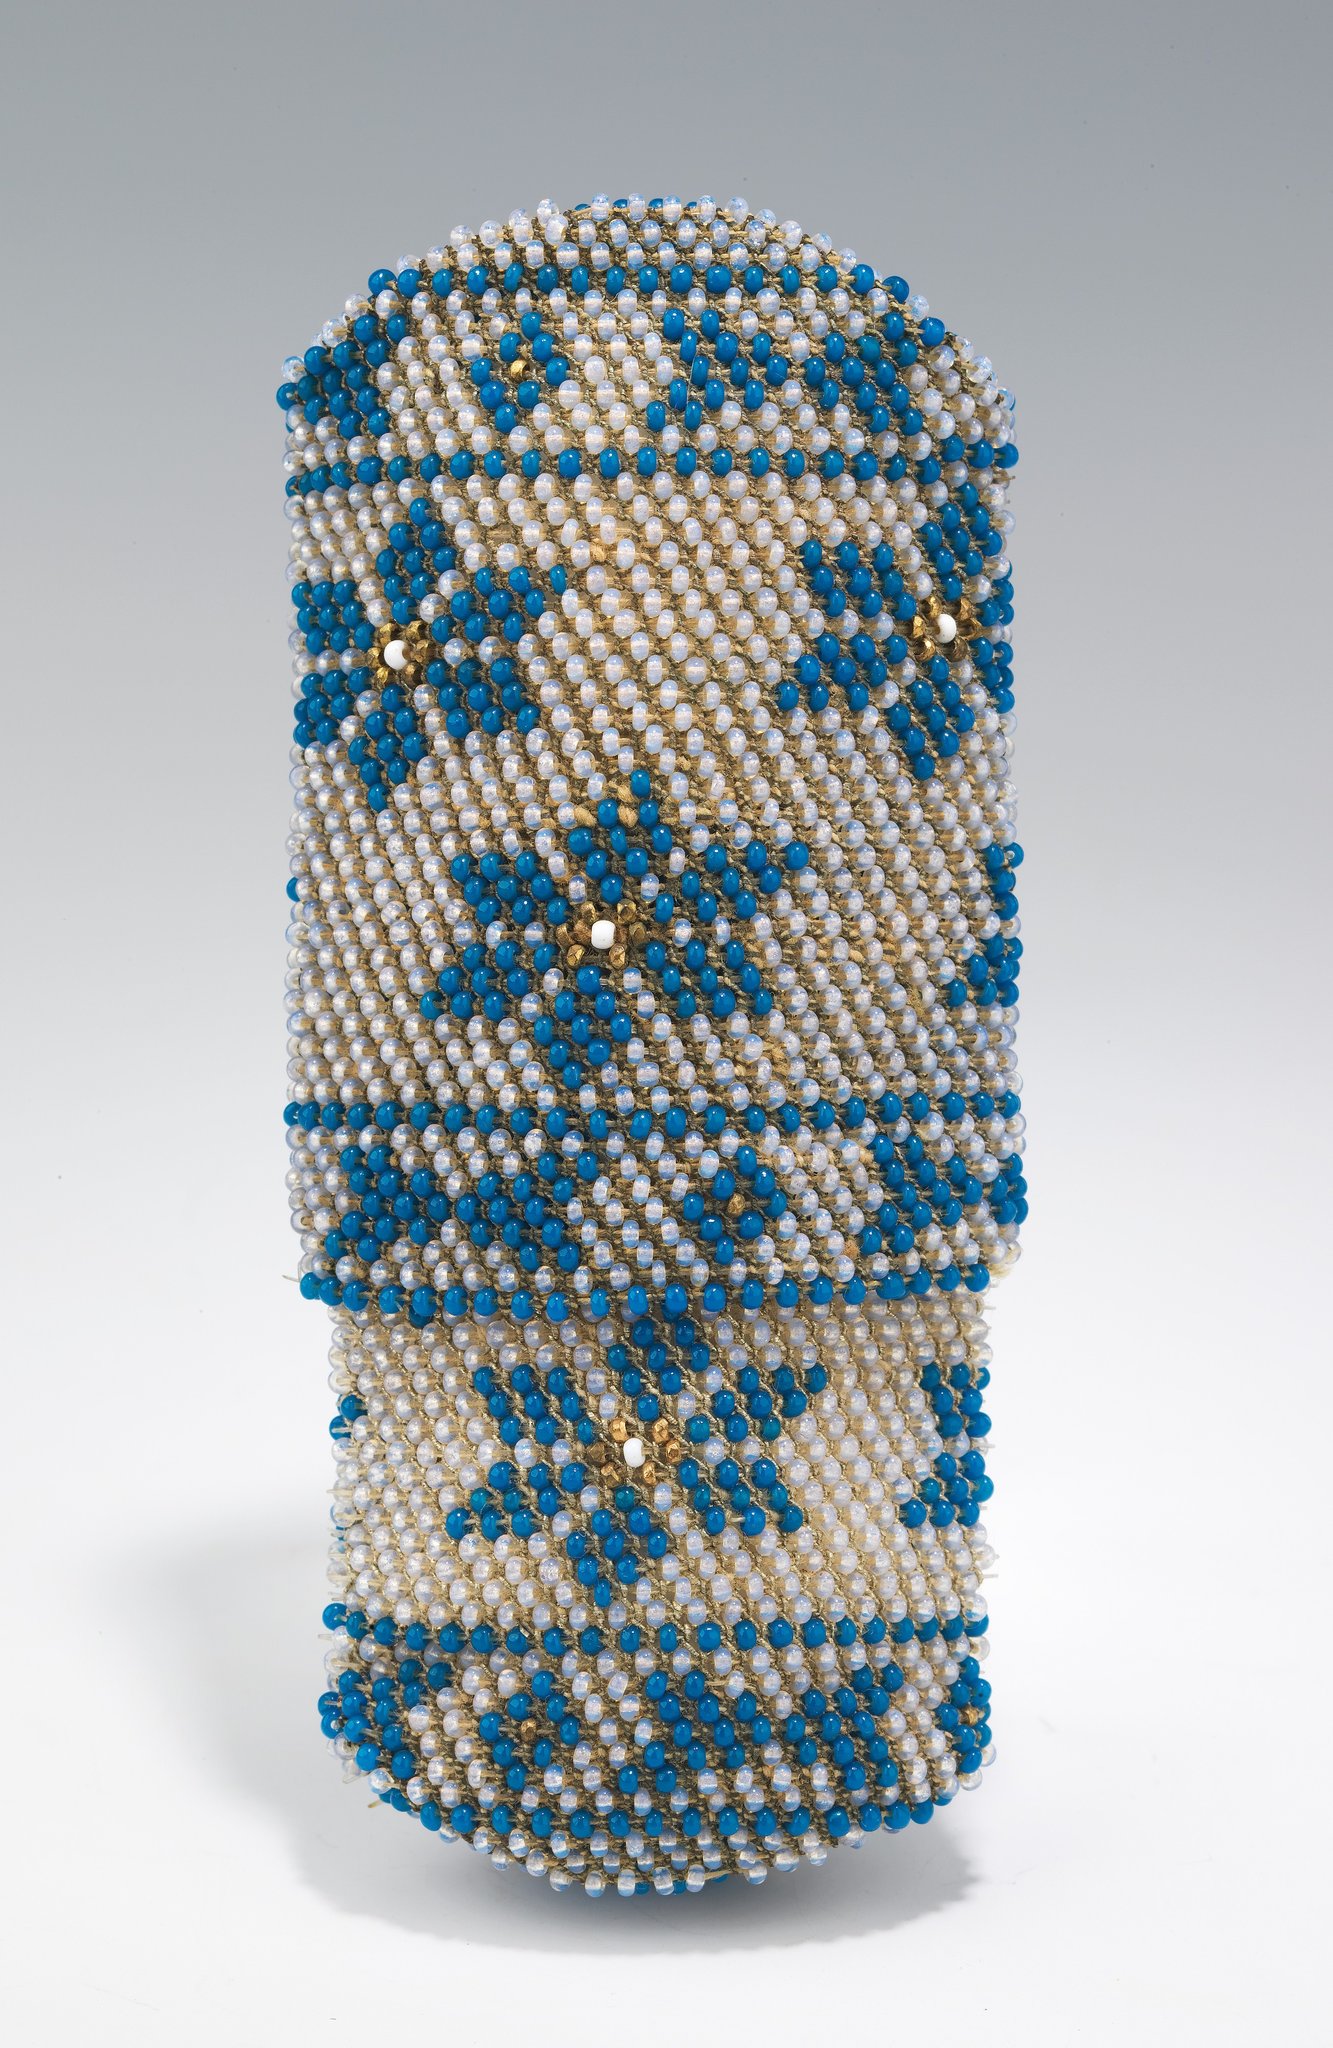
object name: purse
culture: mexican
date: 1867-1900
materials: glass, linen, metal